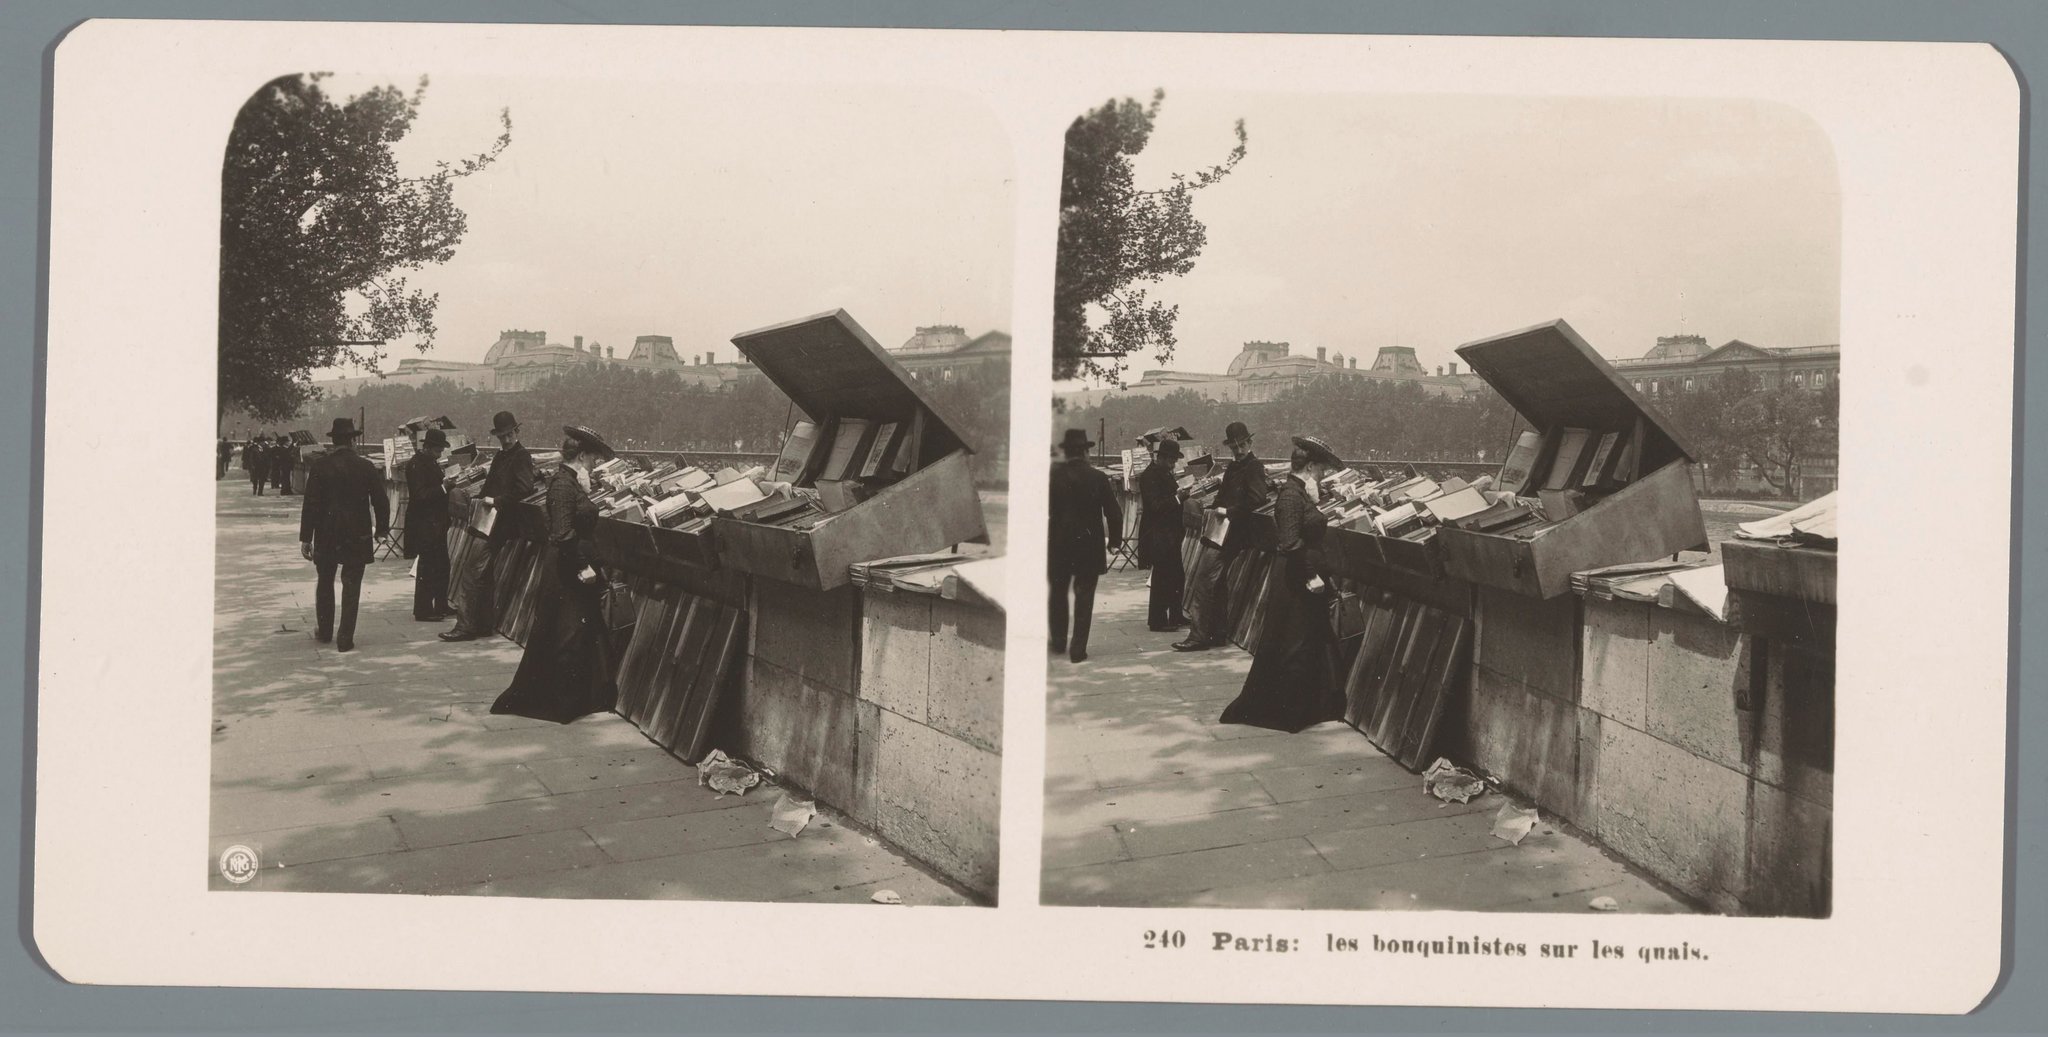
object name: stereograph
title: Paris: les bouquinistes sur les quais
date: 1895-1905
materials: cardboard, photographic support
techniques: gelatin silver print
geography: paris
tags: book, selling, quay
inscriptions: inscription: ‘NPG’, number: ‘240’